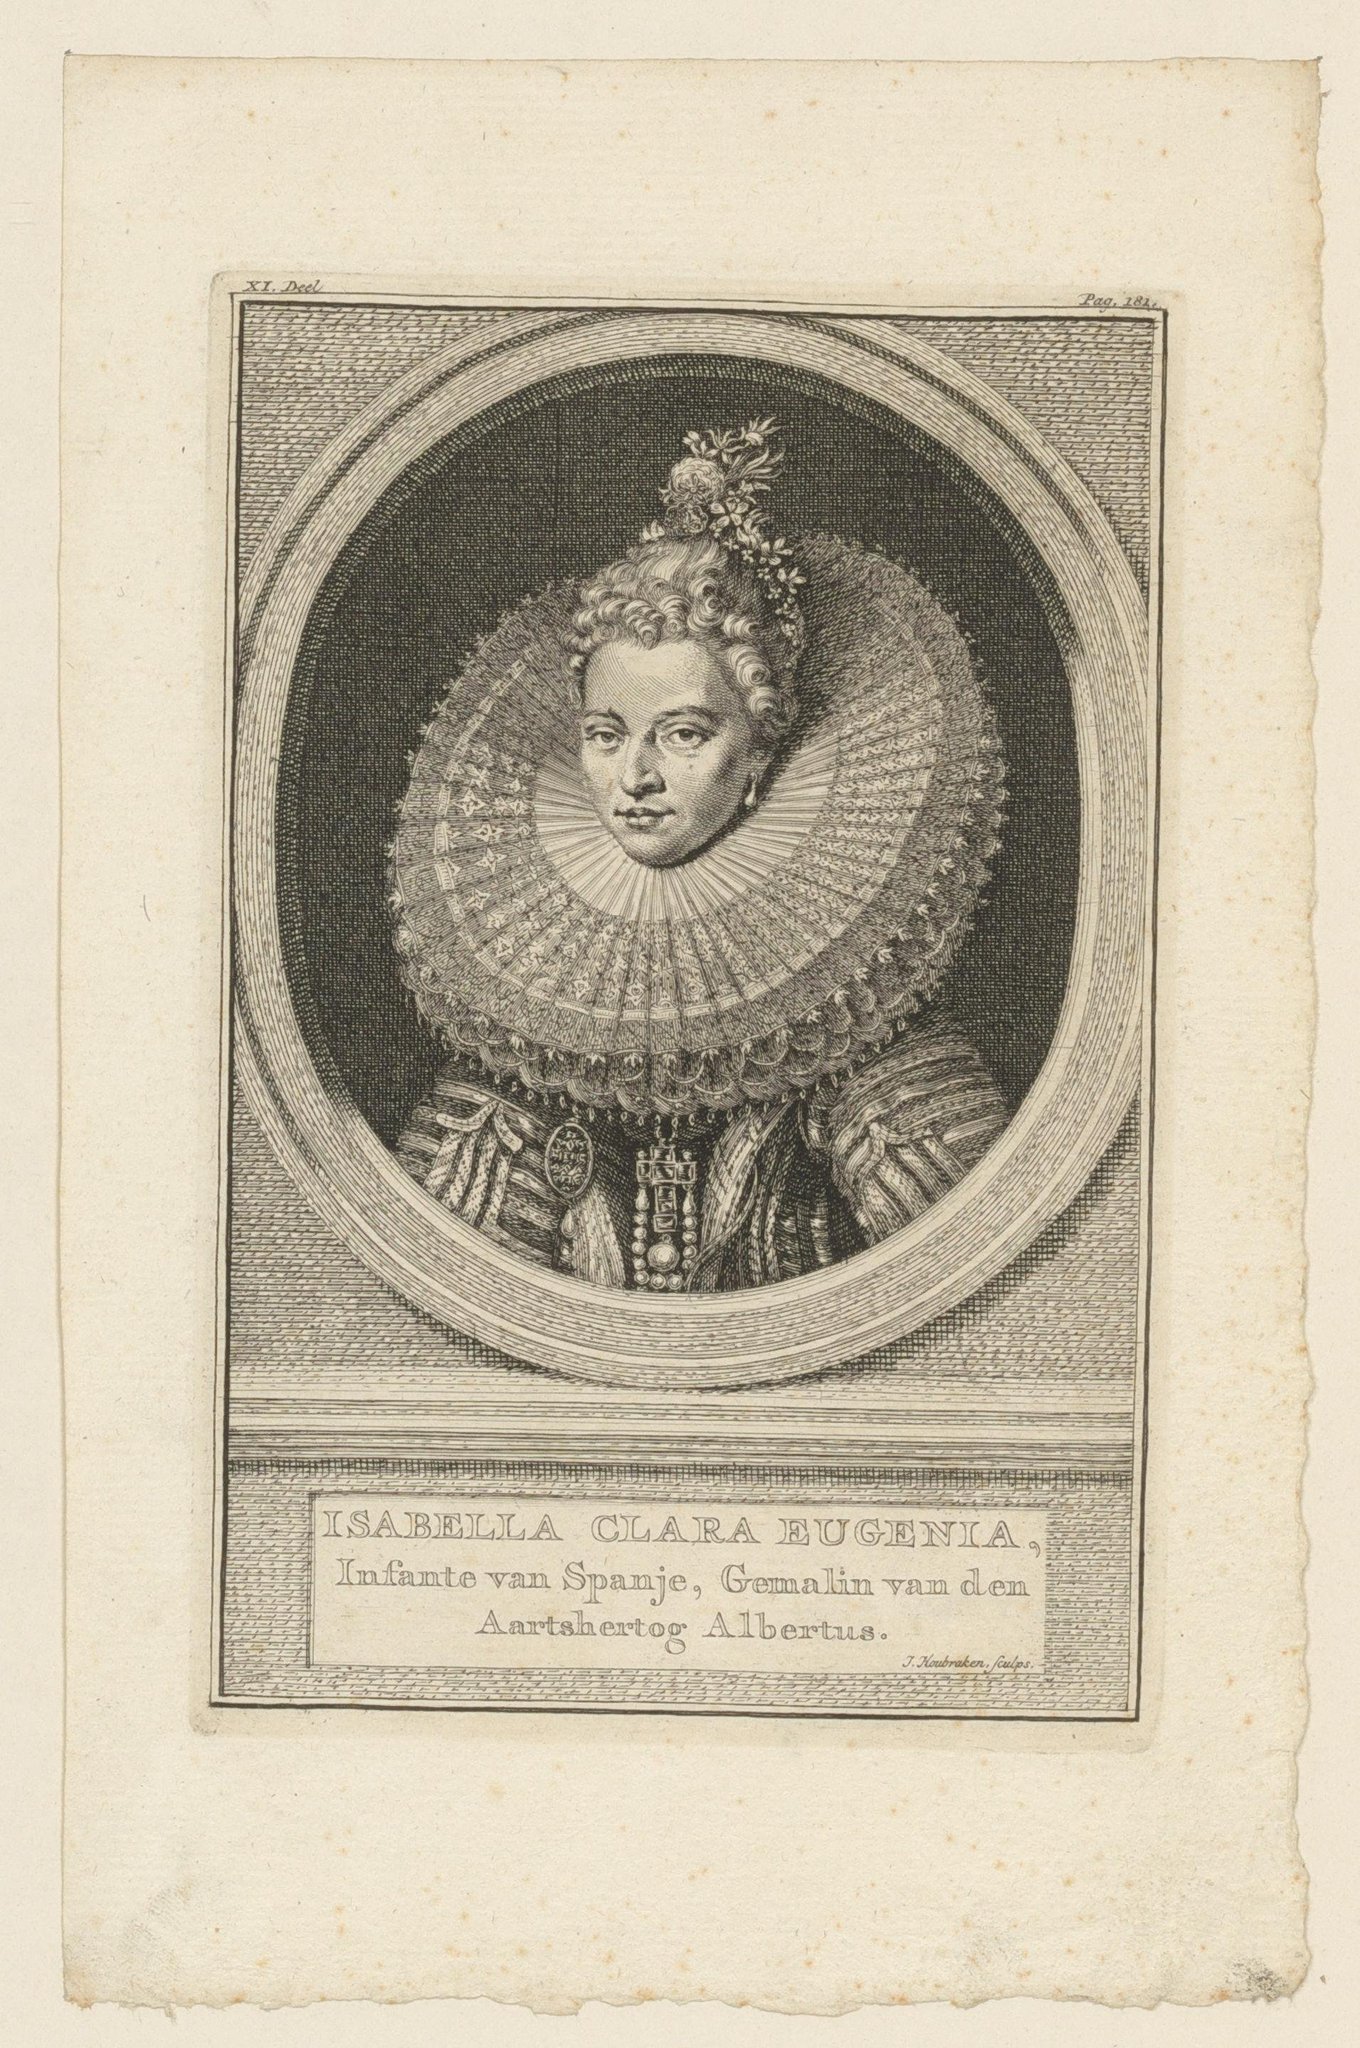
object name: print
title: Isabella Clara Eugenia, Infante van Spanje, Gemalin van den Aartshertog Albertus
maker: jacob houbraken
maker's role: draughtsman, print maker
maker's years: 1698-1780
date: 1749-1796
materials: paper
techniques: engraving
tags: infante van spanje isabella clara eugenia, historical persons - bb - woman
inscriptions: stamp, collector's mark: Lugt 1641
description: Deze prent is oorspronkelijk bedoeld als aanvulling op Jan Wagenaars ‘Vaderlandsche historie’* en was zo vanaf 1796 verkrijgbaar bij Johannes Allart te Amsterdam. Voor de advertentie waarin Allart de 60 portretten en 7 platen, allen gegraveerd door Houbraken, ter aanvulling op Wagenaars ‘Vaderlandsche historie’ aanbiedt, zie RP-P-OB-77.766. *Van dit werk zijn in de achttiende eeuw meerdere uitgaves verschenen, zoals: Wagenaar, Jan. Vaderlandsche historie, vervattende de geschiedenissen der Vereenigde Nederlanden (…). 21 delen. Amsterdam: Isaak Tirion, 1749-1759. Wagenaar, Jan. Vaderlandsche historie, vervattende de geschiedenissen der nu Vereenigde Nederlanden (…). 21 delen. Amsterdam: weduwe Isaak Tirion, 1770. Wagenaar, Jan. Vaderlandsche historie, vervattende de geschiedenissen der nu Vereenigde Nederlanden (…). 21 delen. Amsterdam, Leiden, Dordrecht en Harlingen: P. Schouten e.a., 1782. Wagenaar, Jan. Vaderlandsche historie, vervattende de geschiedenissen der nu Vereenigde Nederlanden (…). 21 delen. Amsterdam: Johannes Allart, 1790-1796.